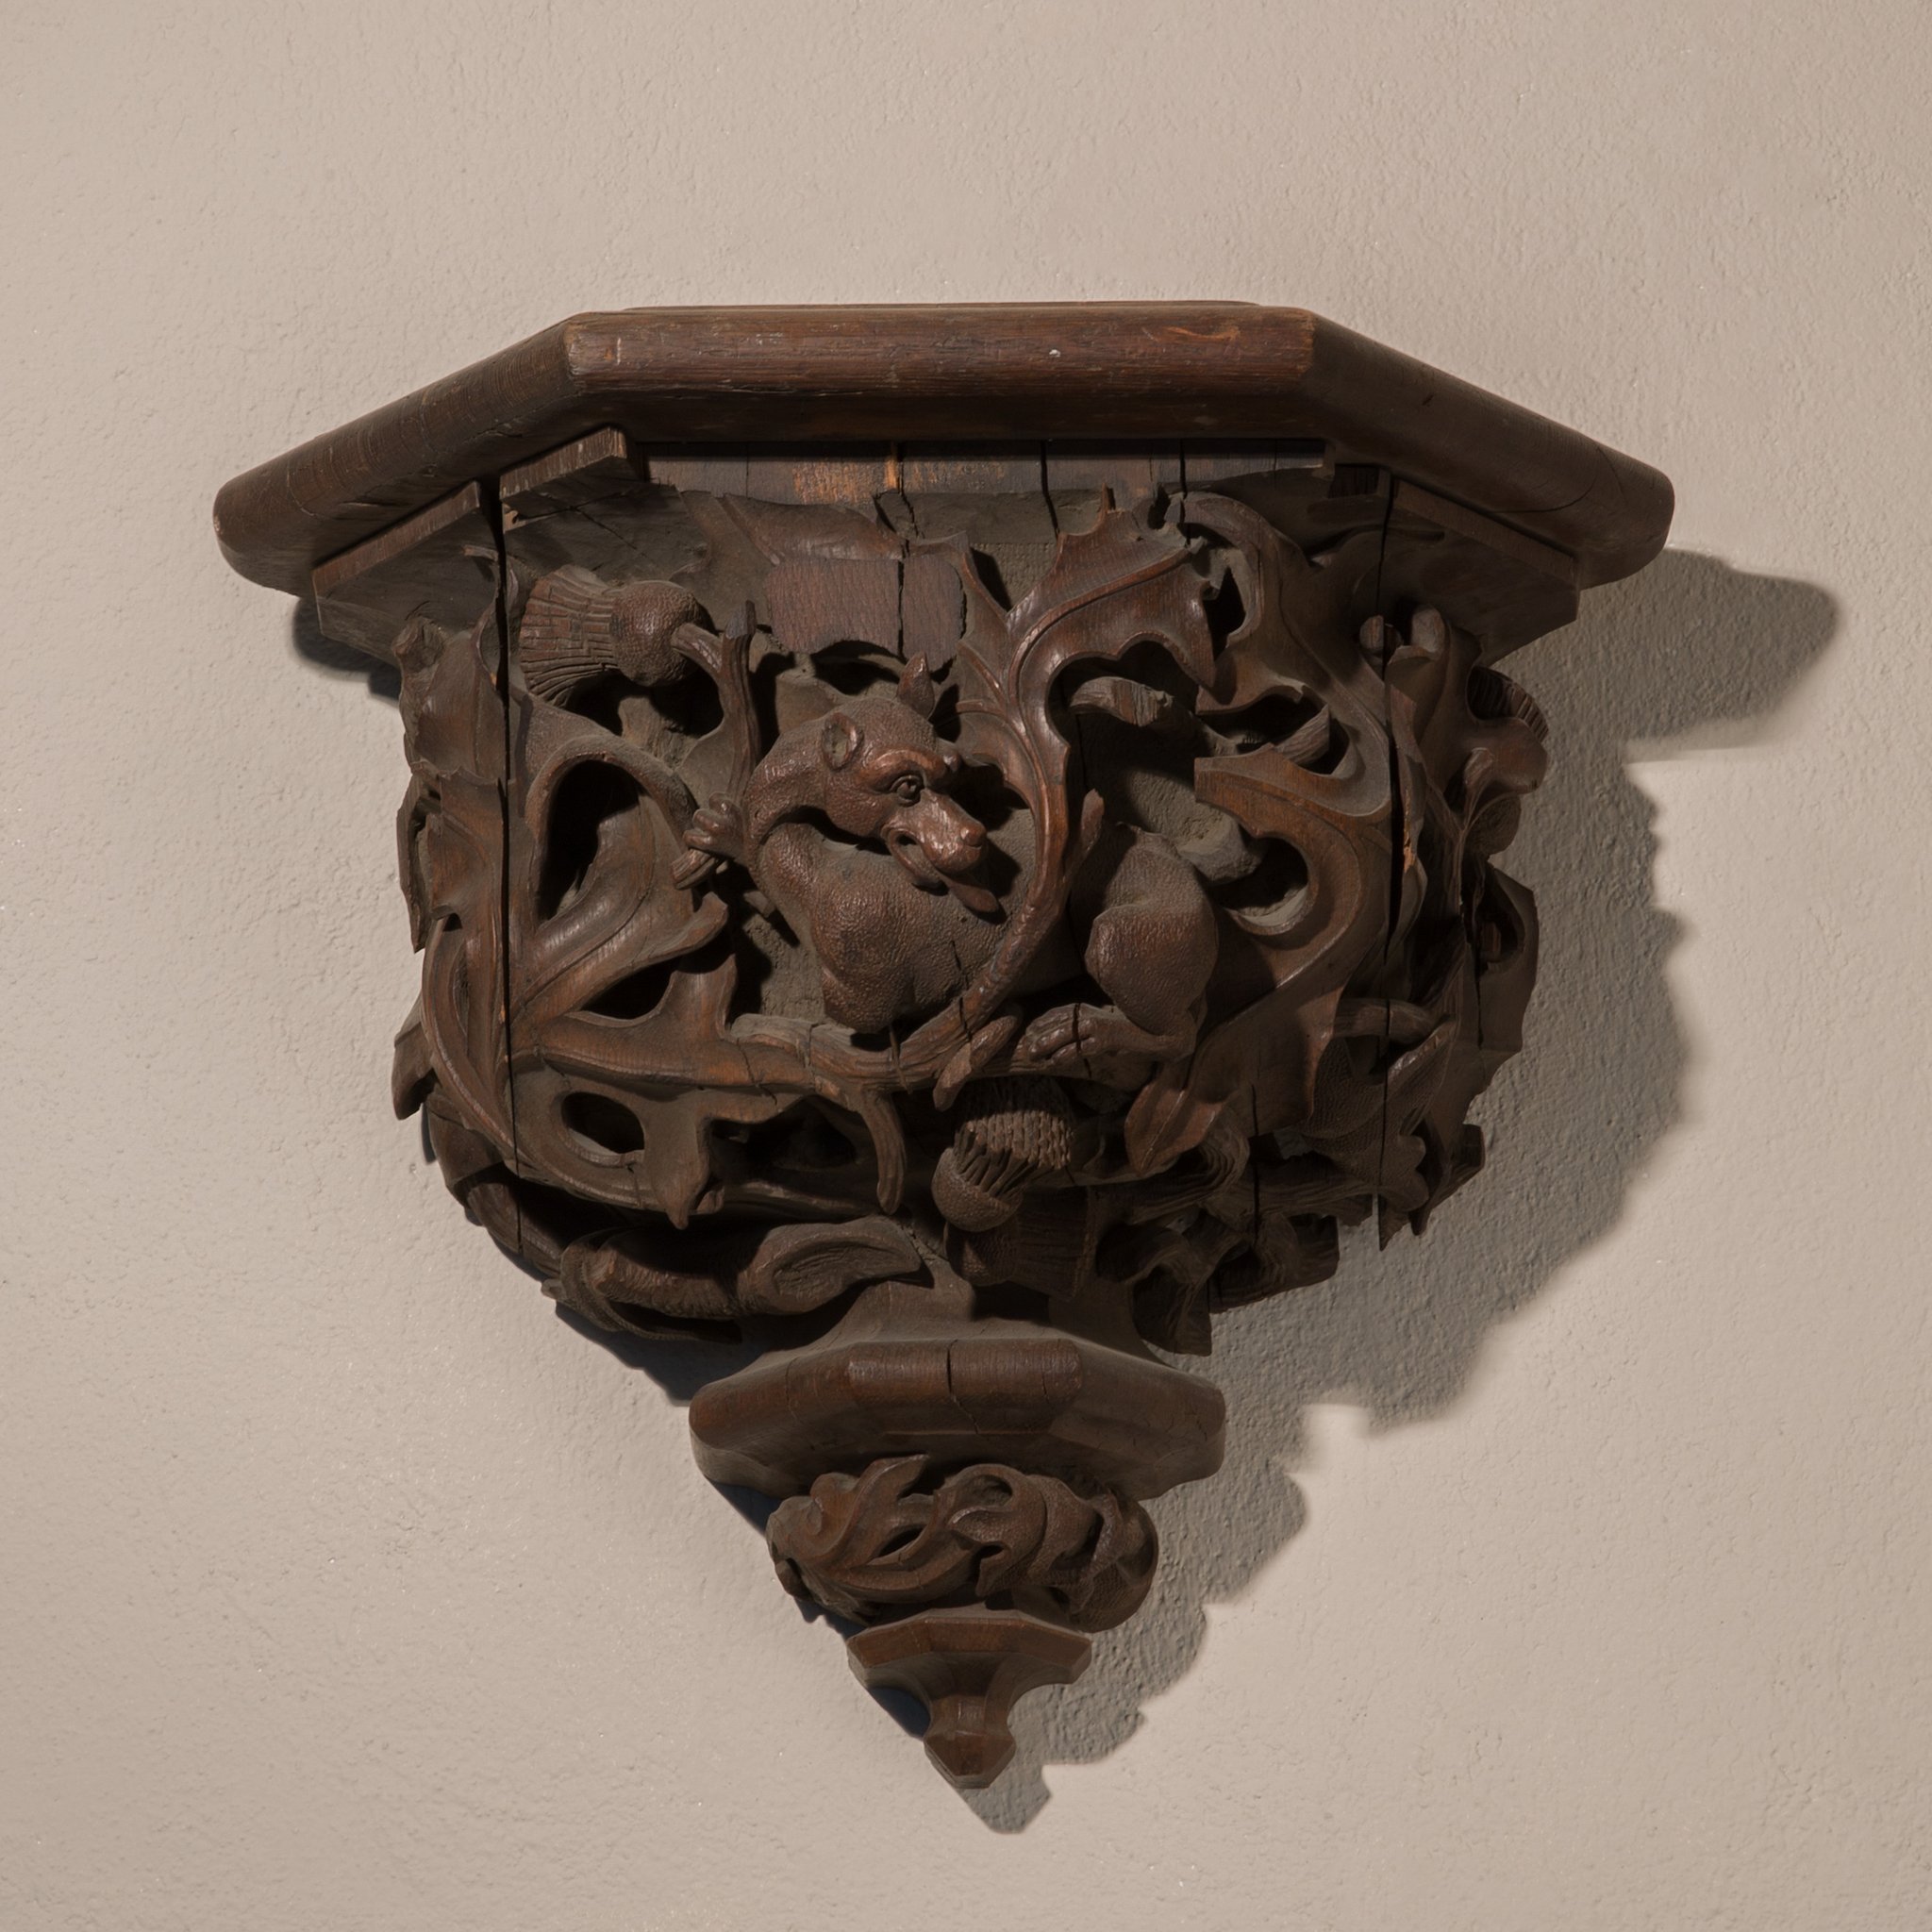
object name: corbel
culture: french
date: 1401-1500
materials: wood